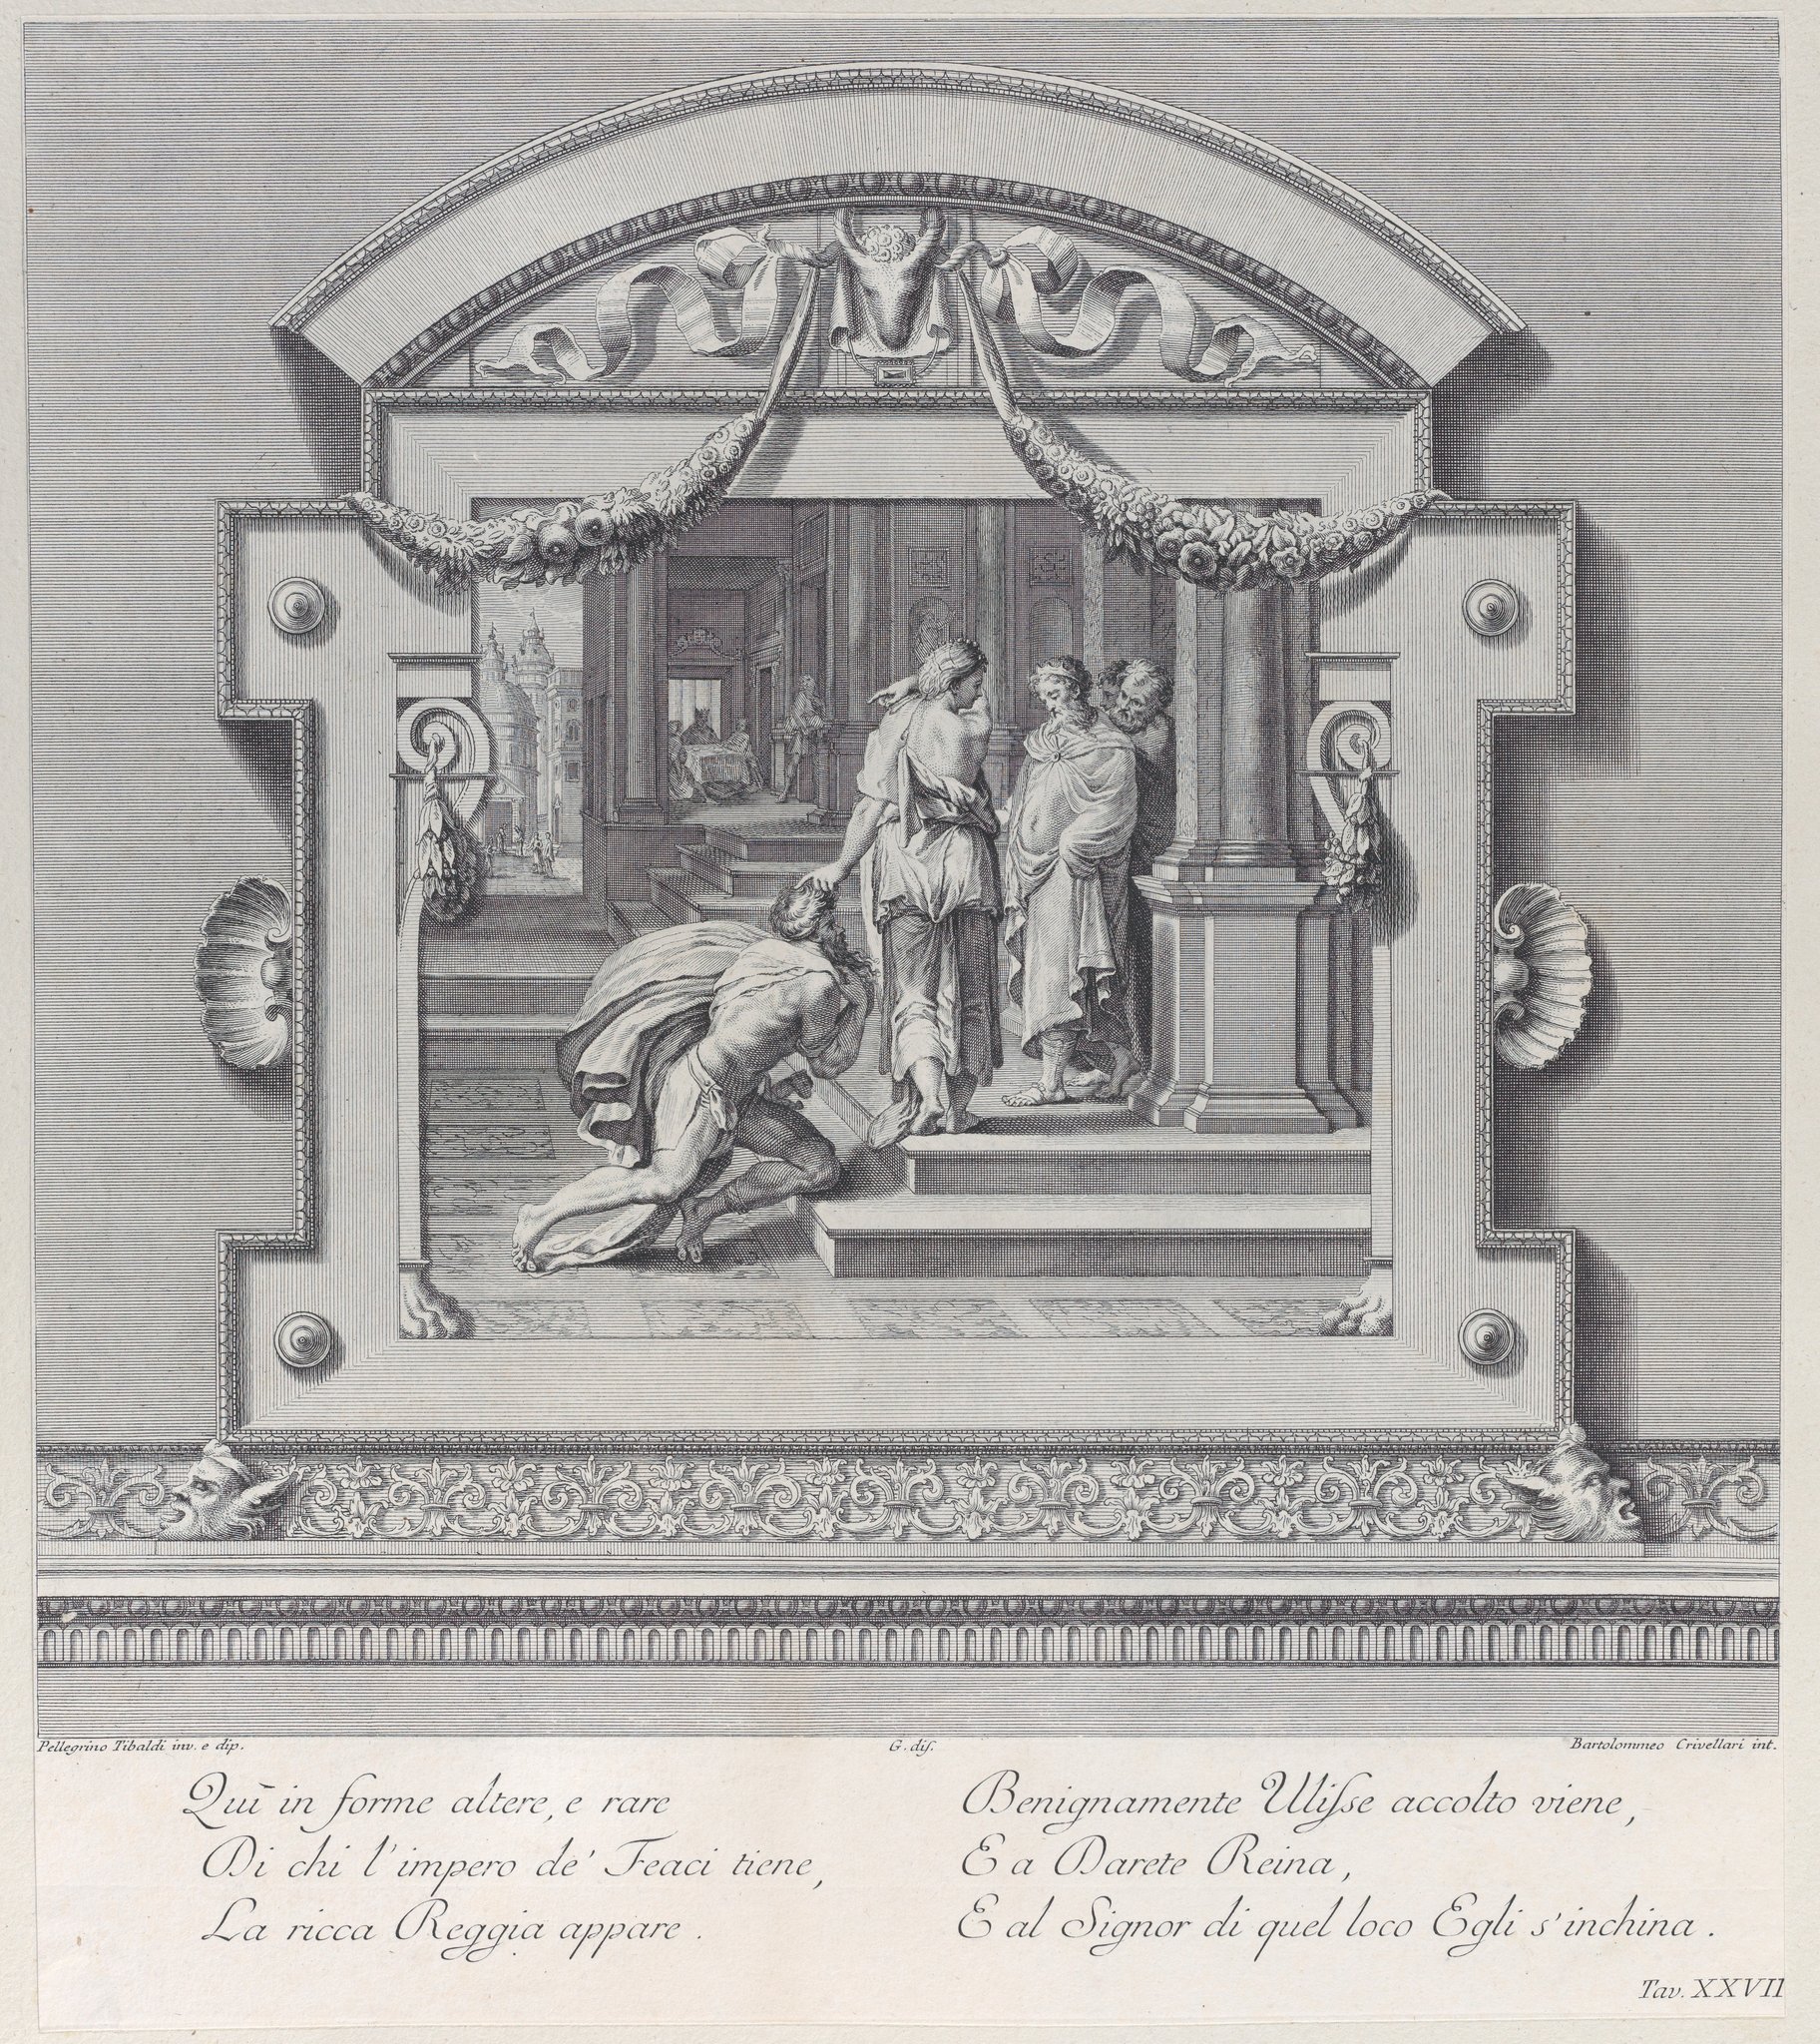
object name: print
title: Plate 27: Ulysses received by Alcinous king of Phoeacia and his Queen Areta after his shipwreck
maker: bartolomeo crivellari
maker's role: artist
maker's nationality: italian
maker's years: 1700-1800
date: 1756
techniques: engraving, etching